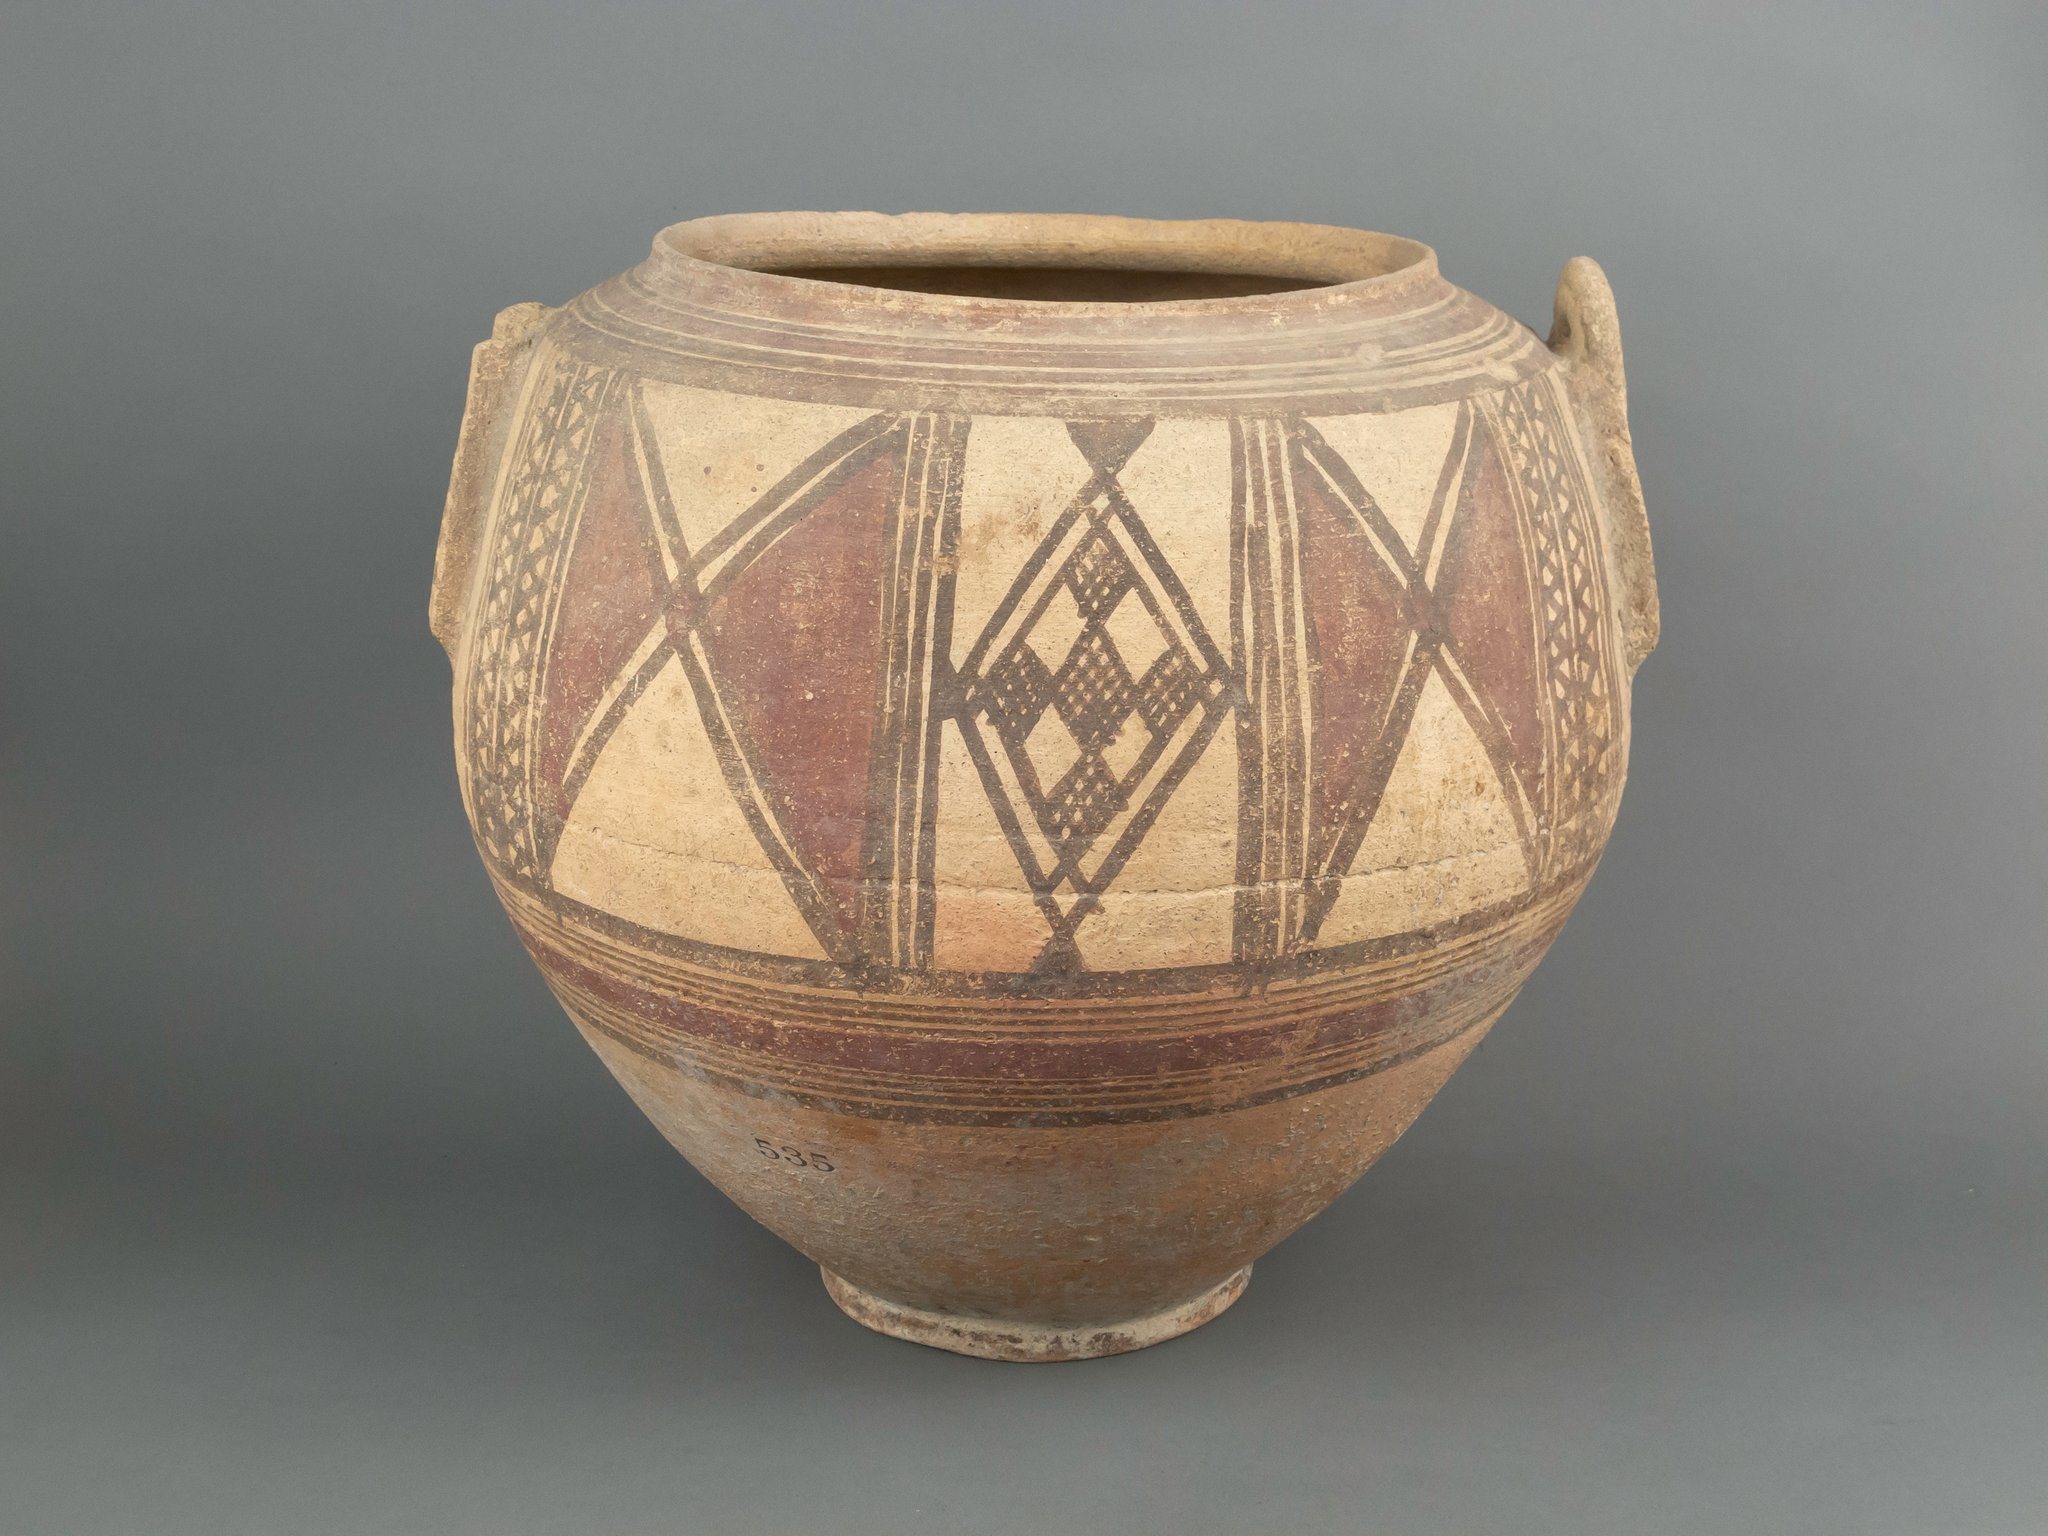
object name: dinos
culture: cypriot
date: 850-750 BCE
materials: terracotta